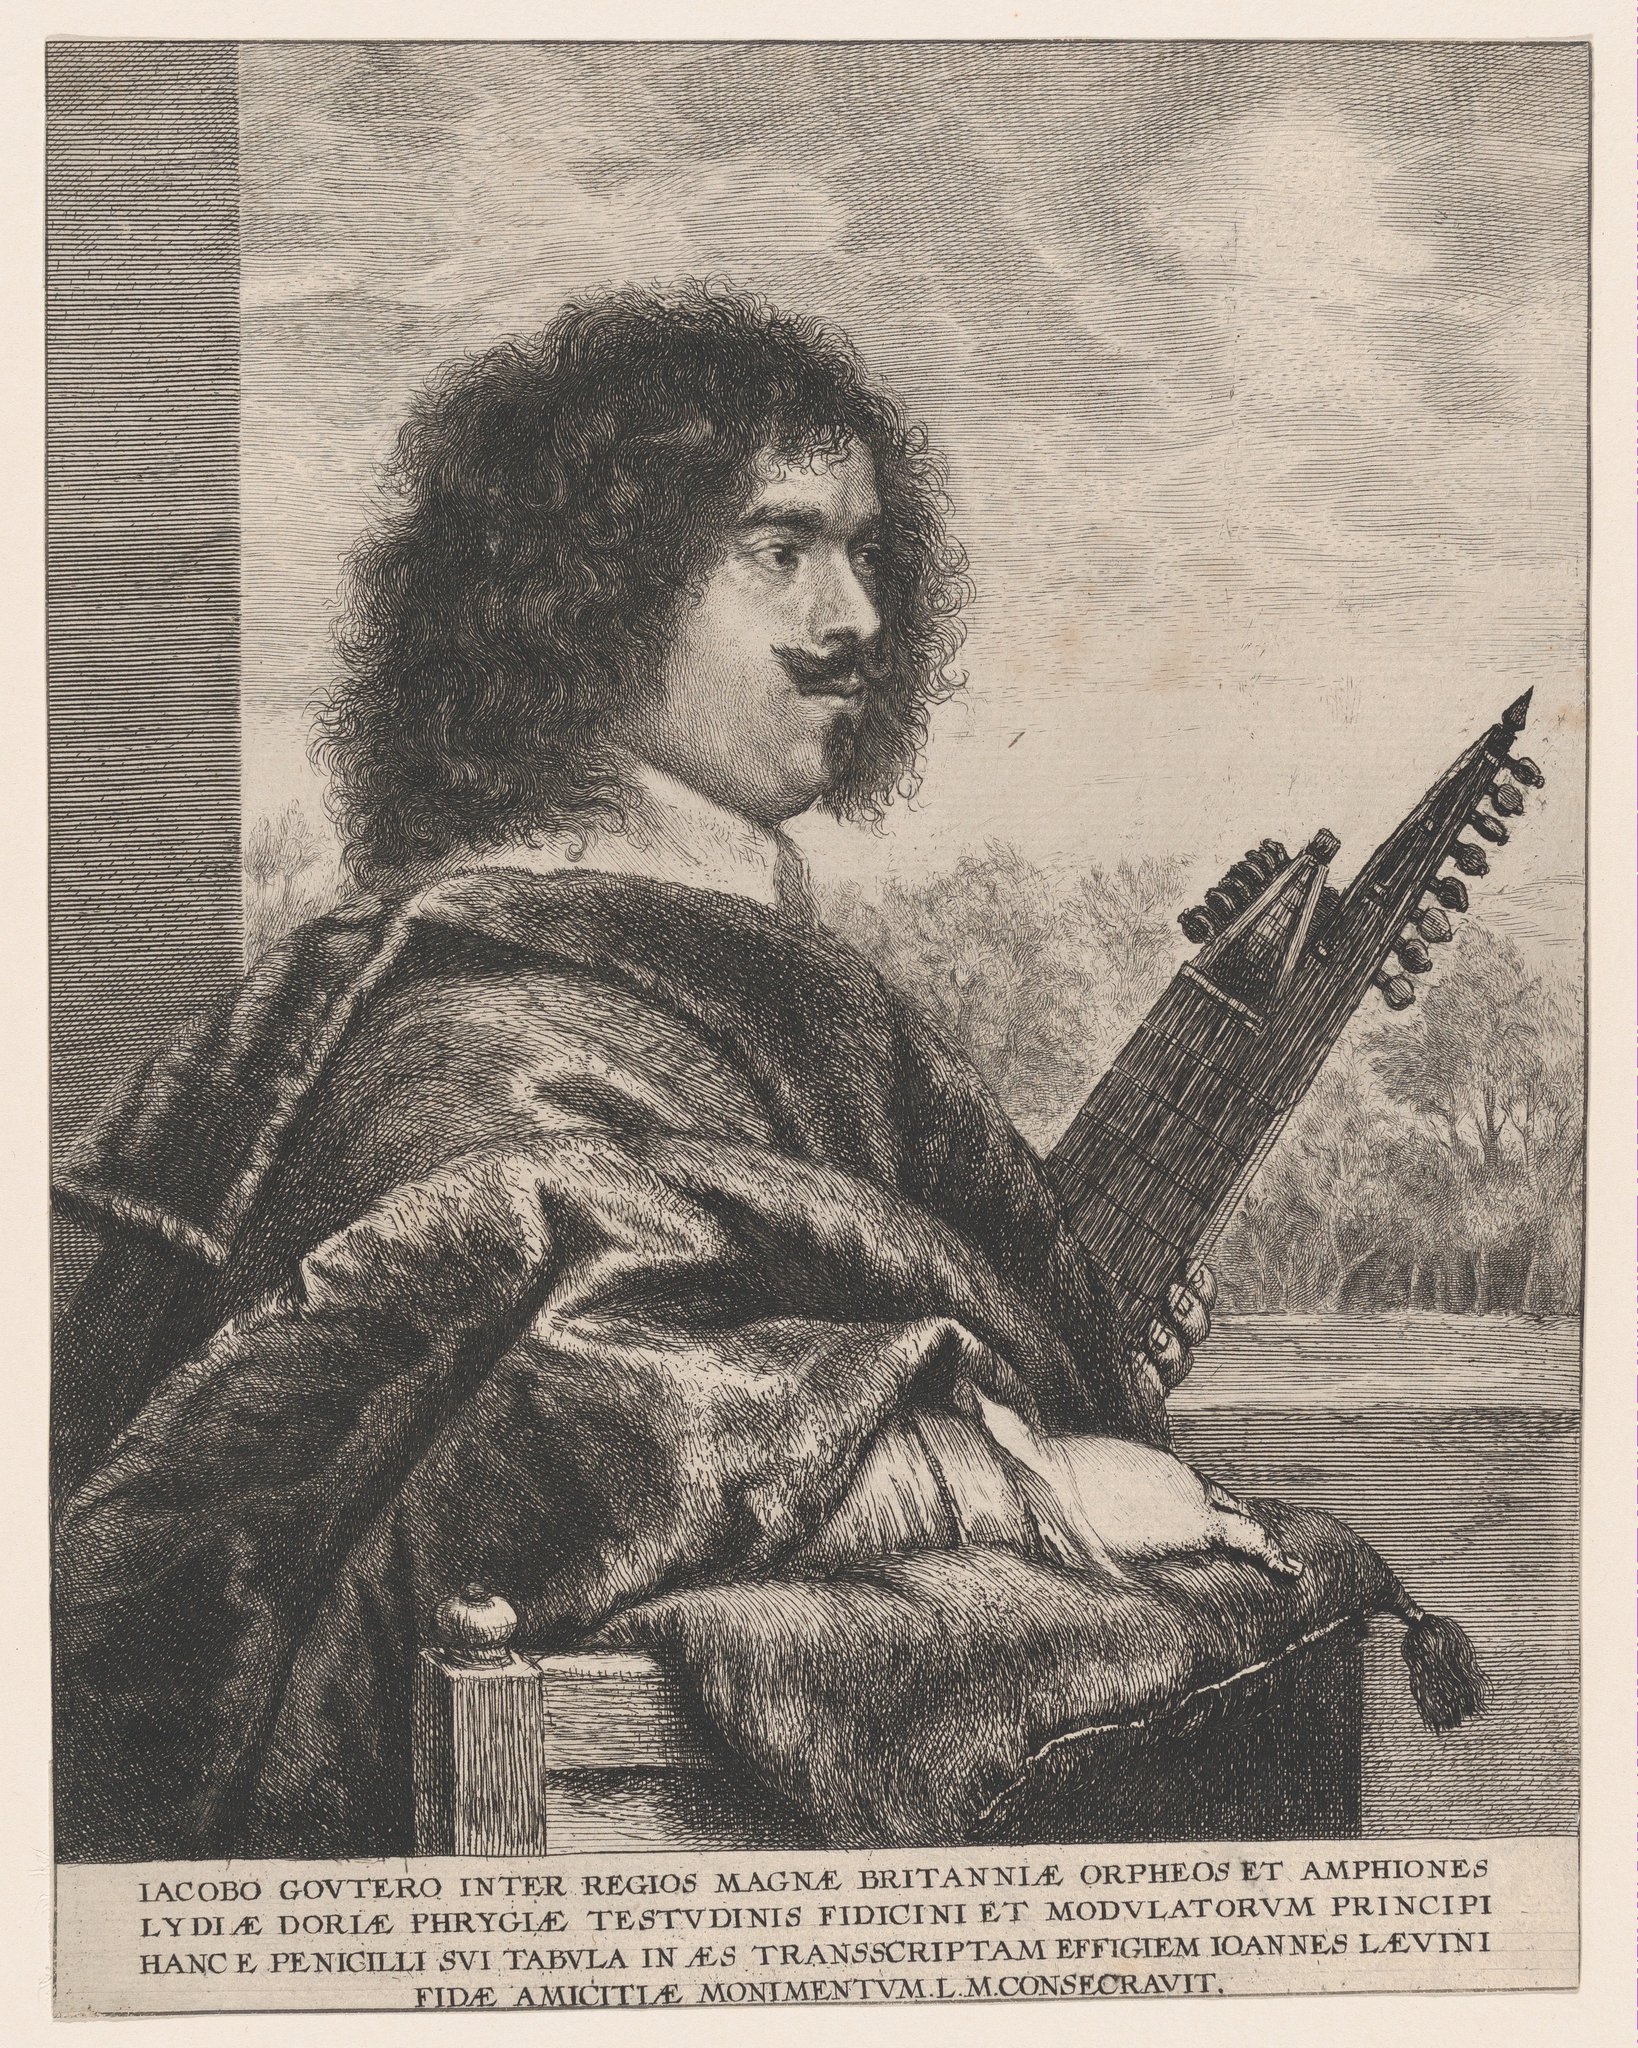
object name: print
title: Jacques Gaultier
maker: jan lievens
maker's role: artist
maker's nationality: dutch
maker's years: 1607-1674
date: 1601-1700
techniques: etching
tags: musical instruments,men,portraits